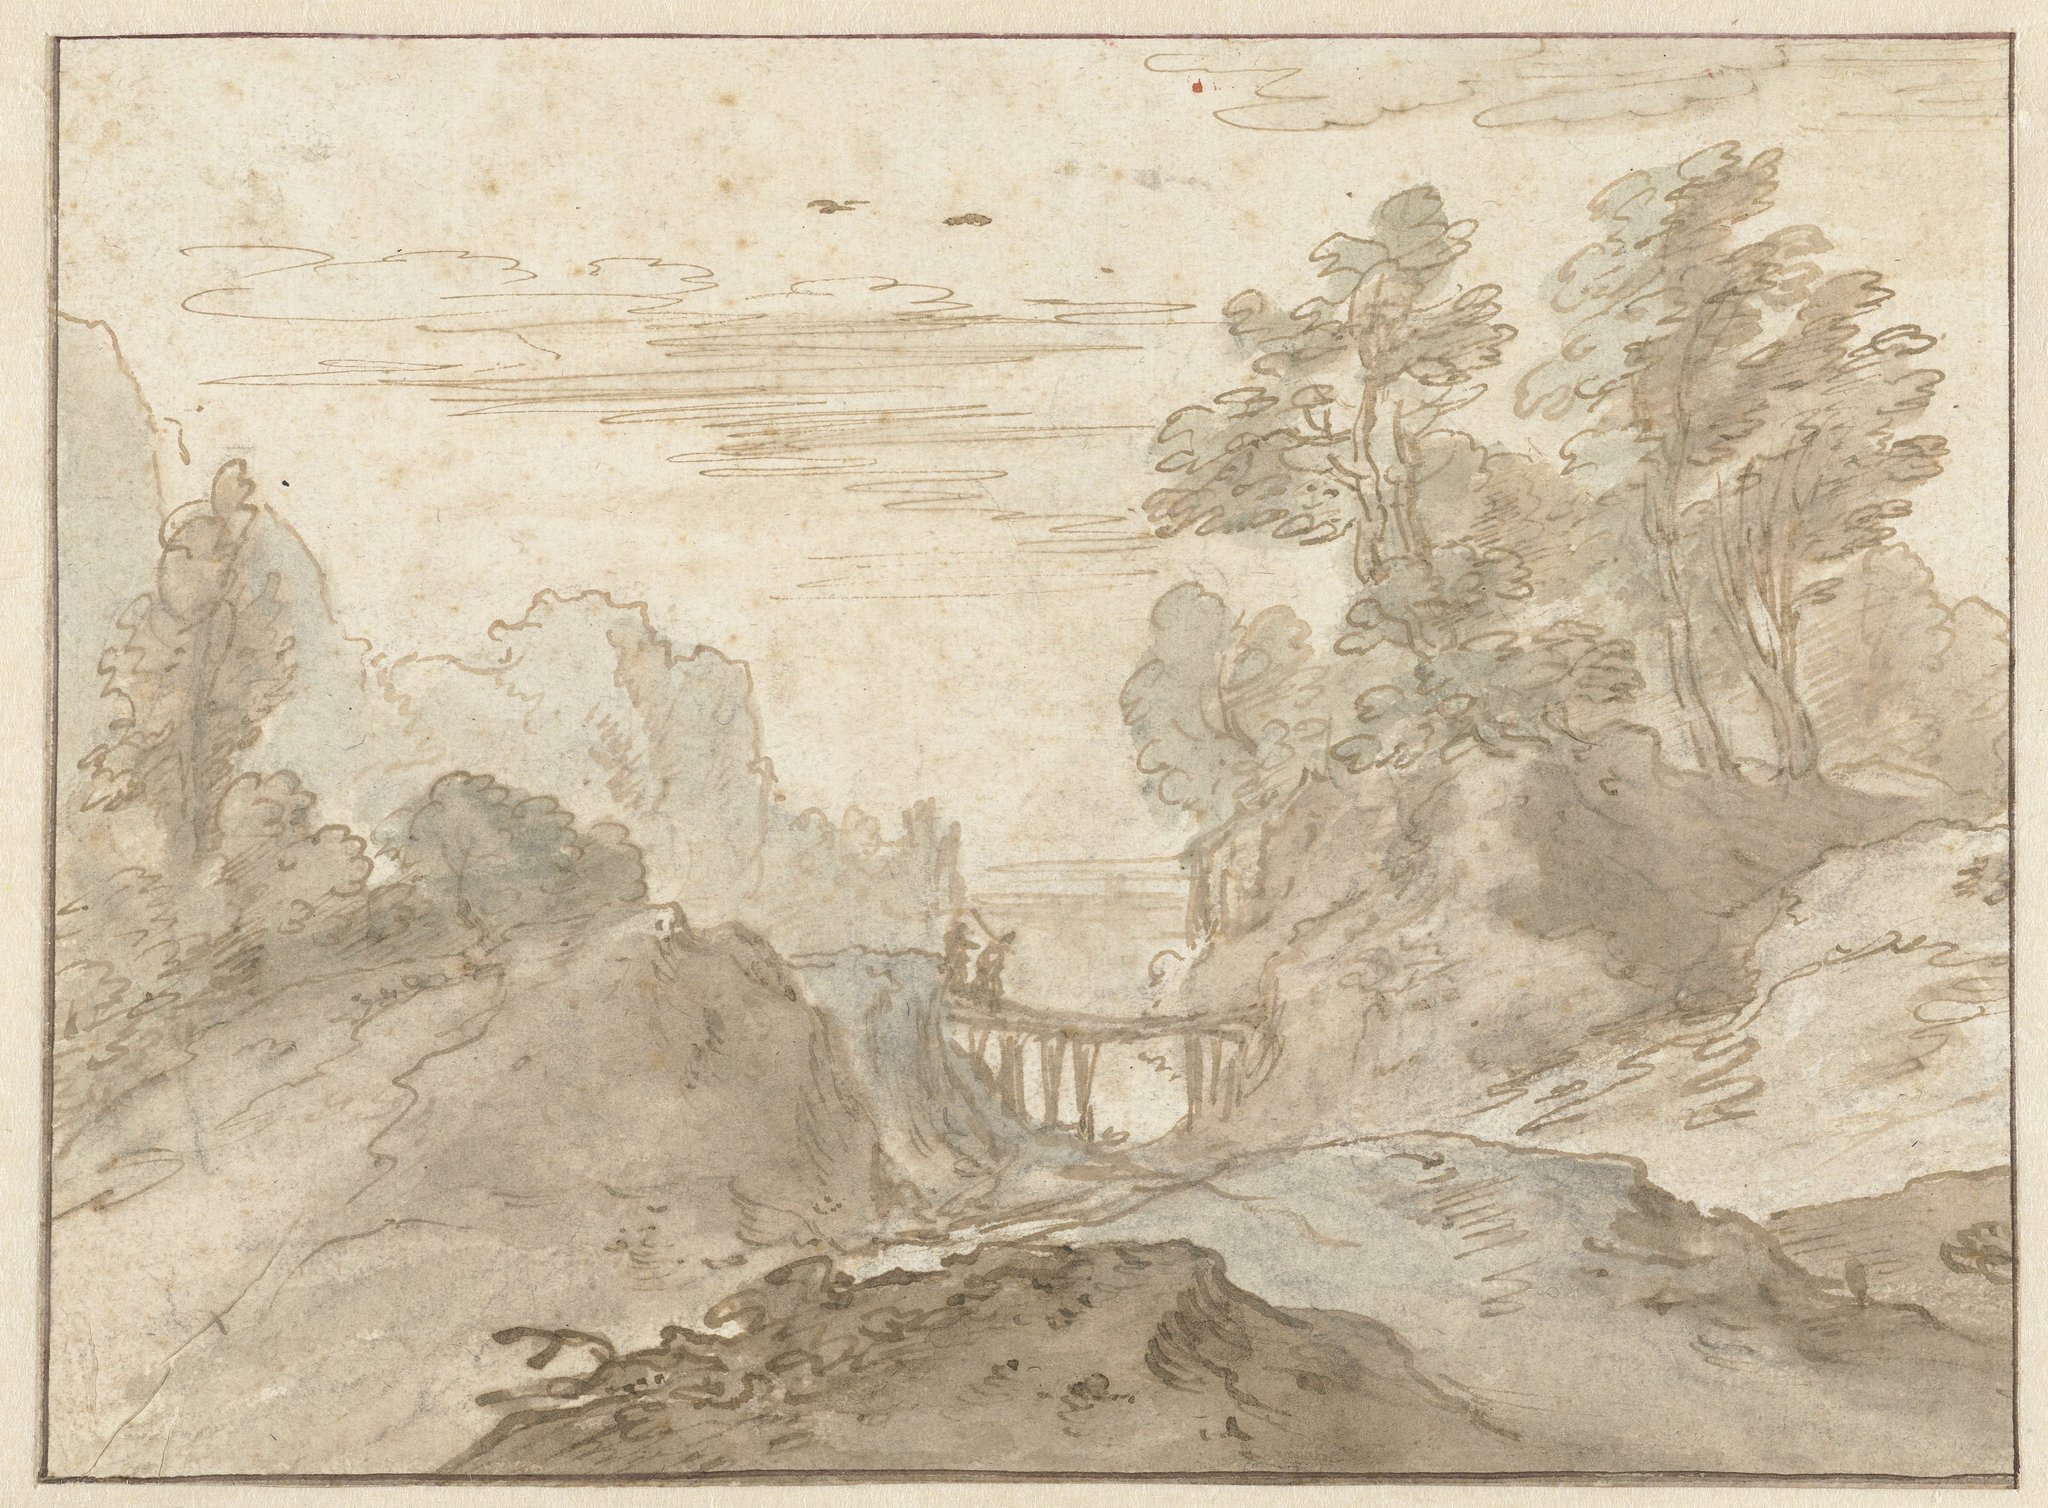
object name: drawing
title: Berglandschap met twee figuren op een smalle brug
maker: pieter dircksz van santvoort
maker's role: draughtsman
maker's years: 1604-1653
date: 1615-1653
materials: ink, paper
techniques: brush, pen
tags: low hill country, landscape with bridge, viaduct or aqueduct